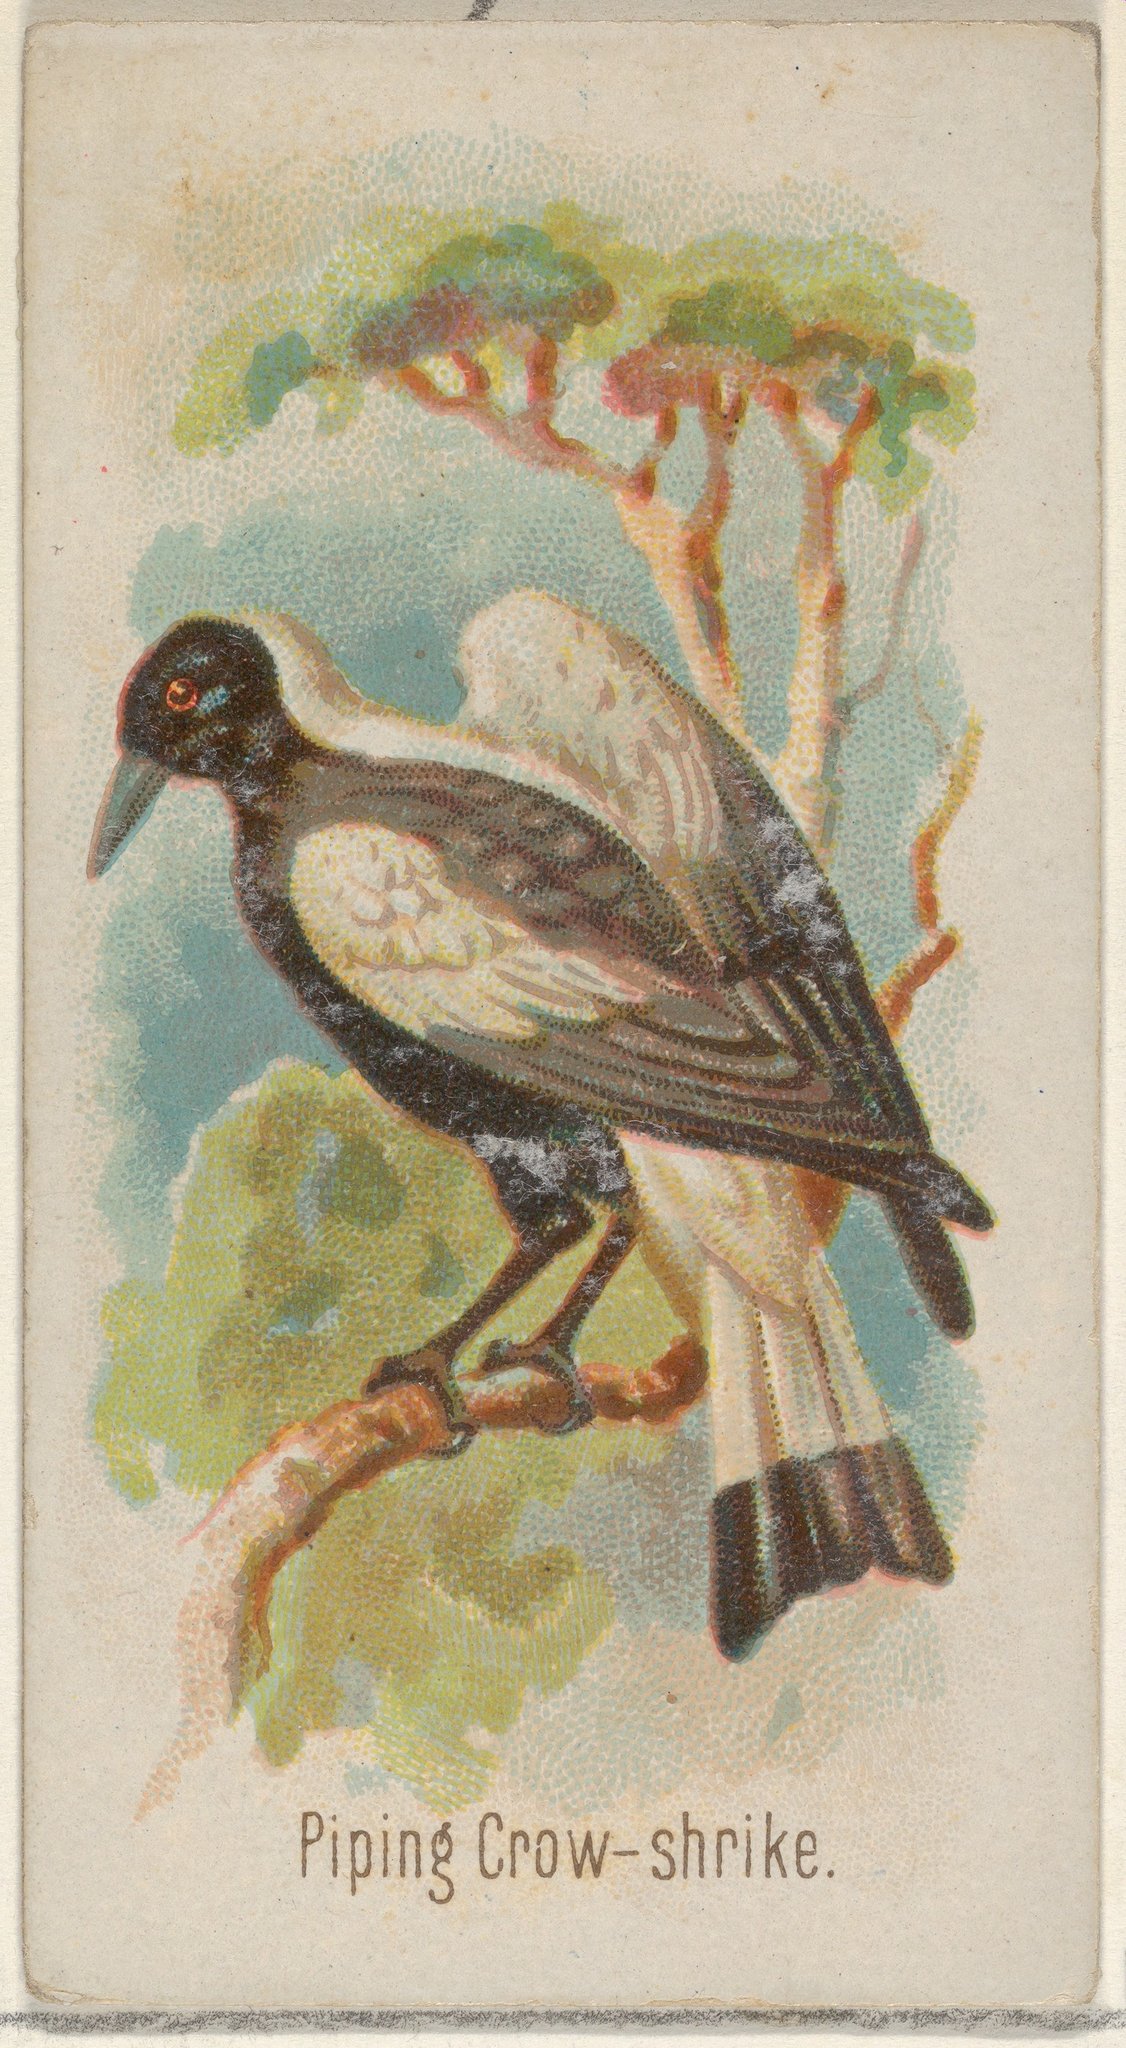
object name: print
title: Piping Crow-shrike, from the Song Birds of the World series (N23) for Allen & Ginter Cigarettes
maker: allen & ginter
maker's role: publisher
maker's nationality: american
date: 1890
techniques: color lithograph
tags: birds